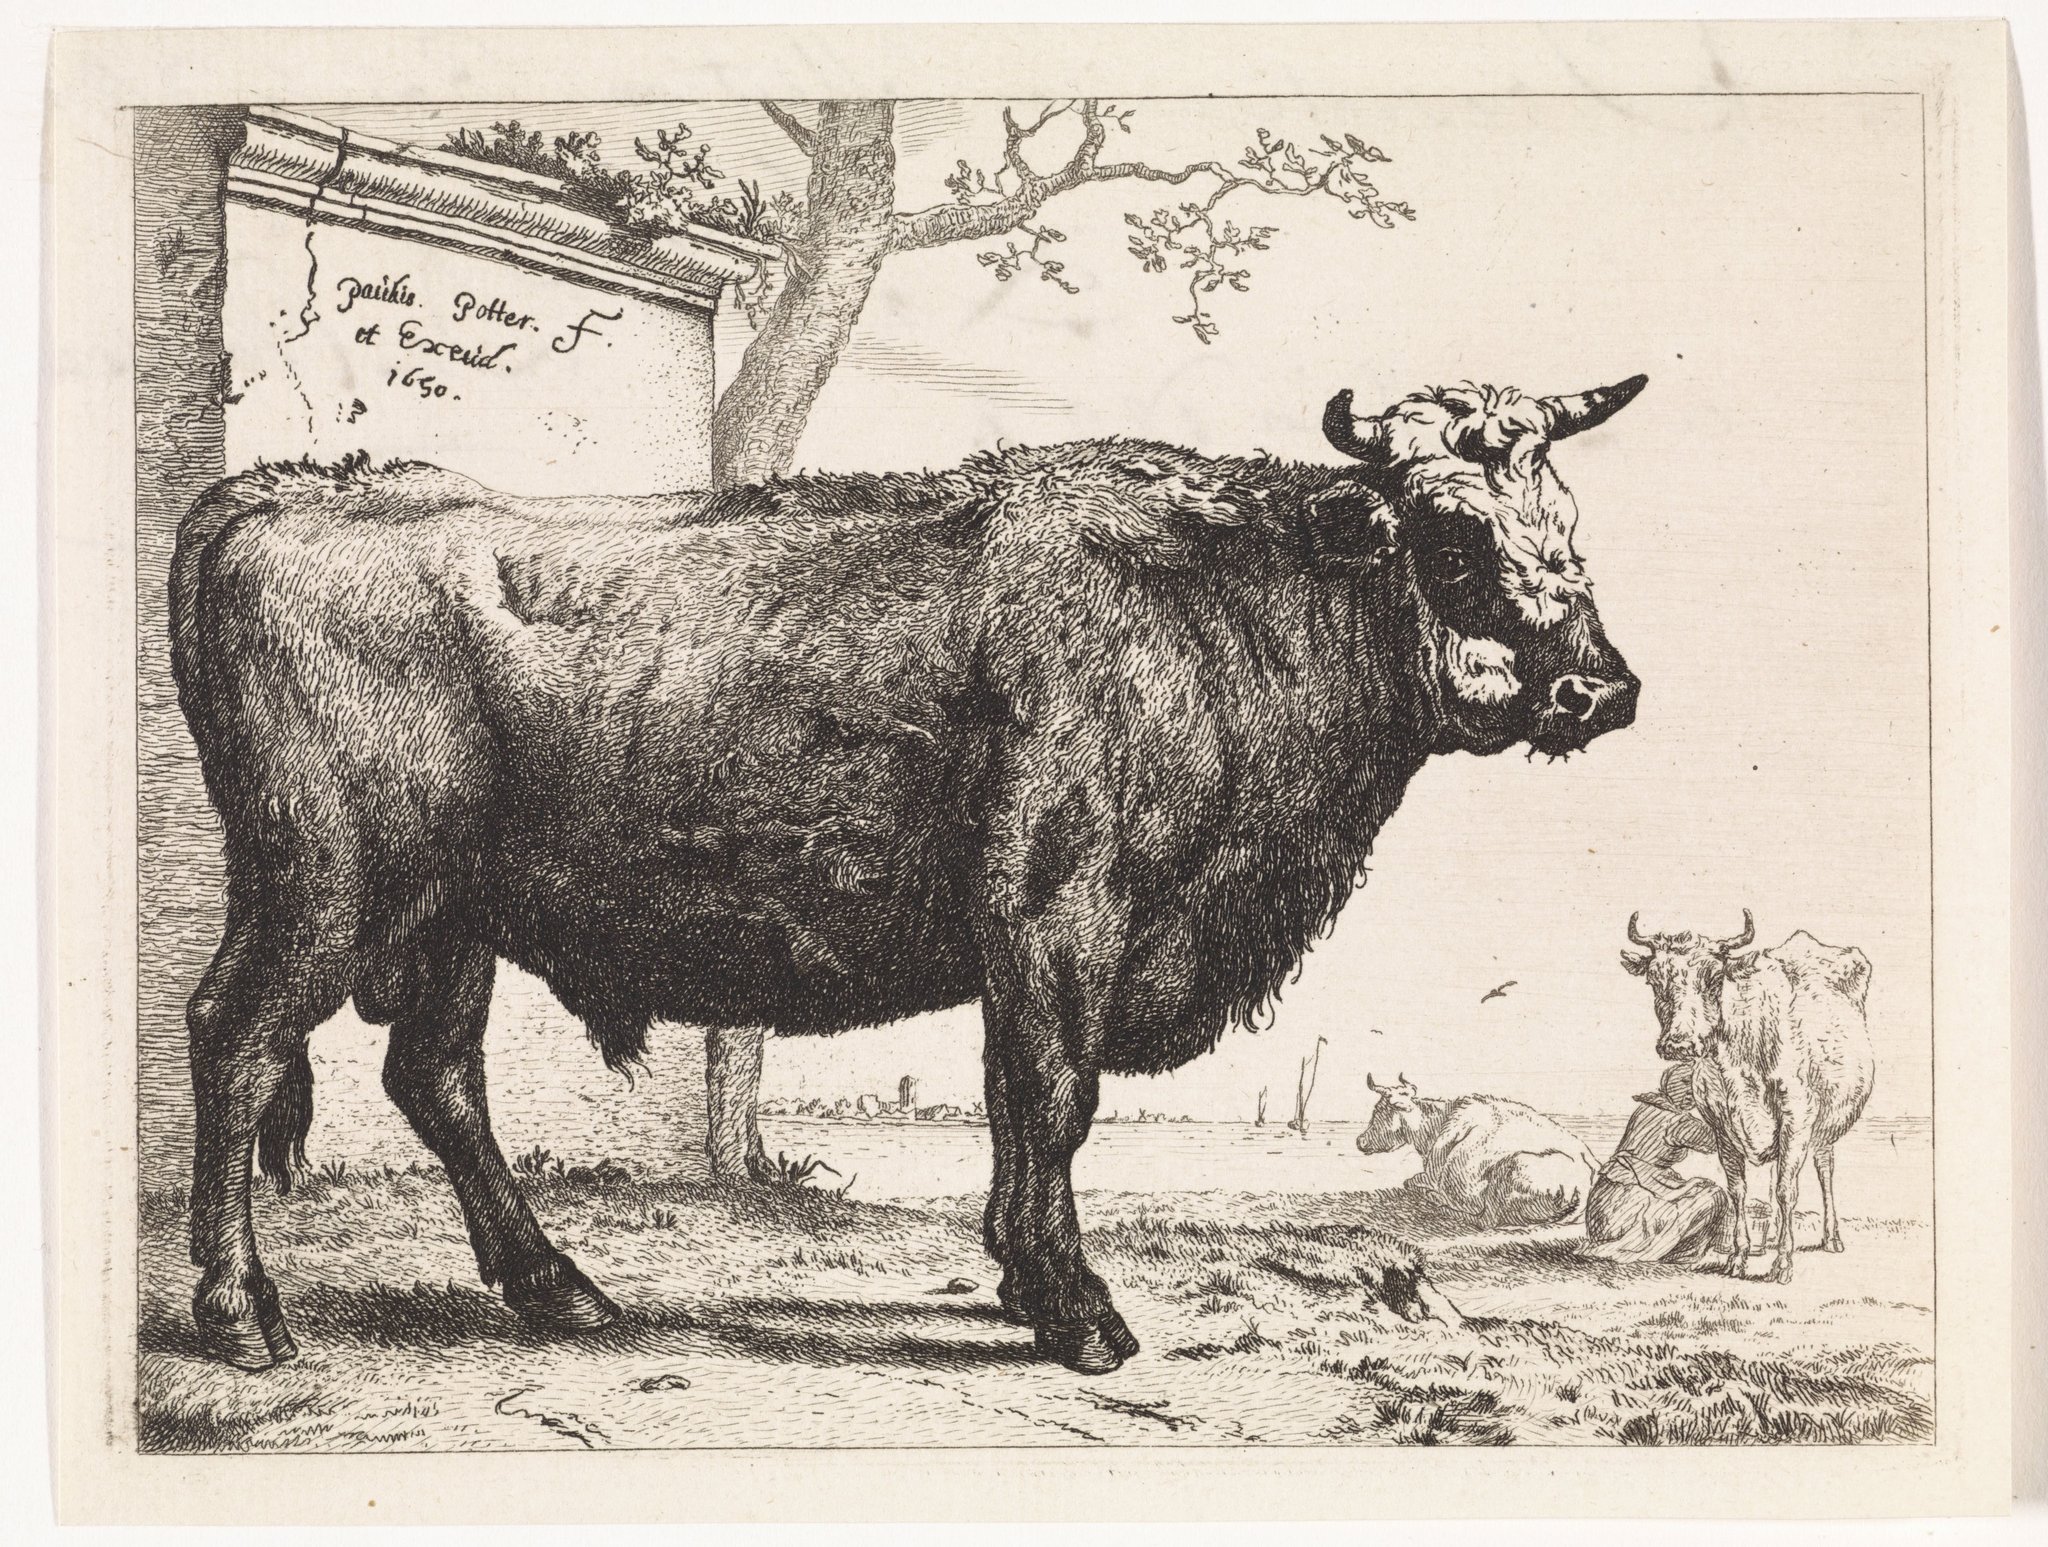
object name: titelprent, frontispice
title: Het Bullenboekje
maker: Anonymous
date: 1650-1700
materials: paper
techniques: etching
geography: netherlands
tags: bull, milking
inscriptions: collector's mark: Lugt 2228, inscription: ‘Presenté à la Collection Royale d'Am [...] a 28 Juin 1824’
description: Landschap met een blaarkopstier. Rechts op de achtergrond twee koeien, waarvan er één wordt gemolken door een meisje. Op de achtergrond een meer en een gezicht op een dorp.